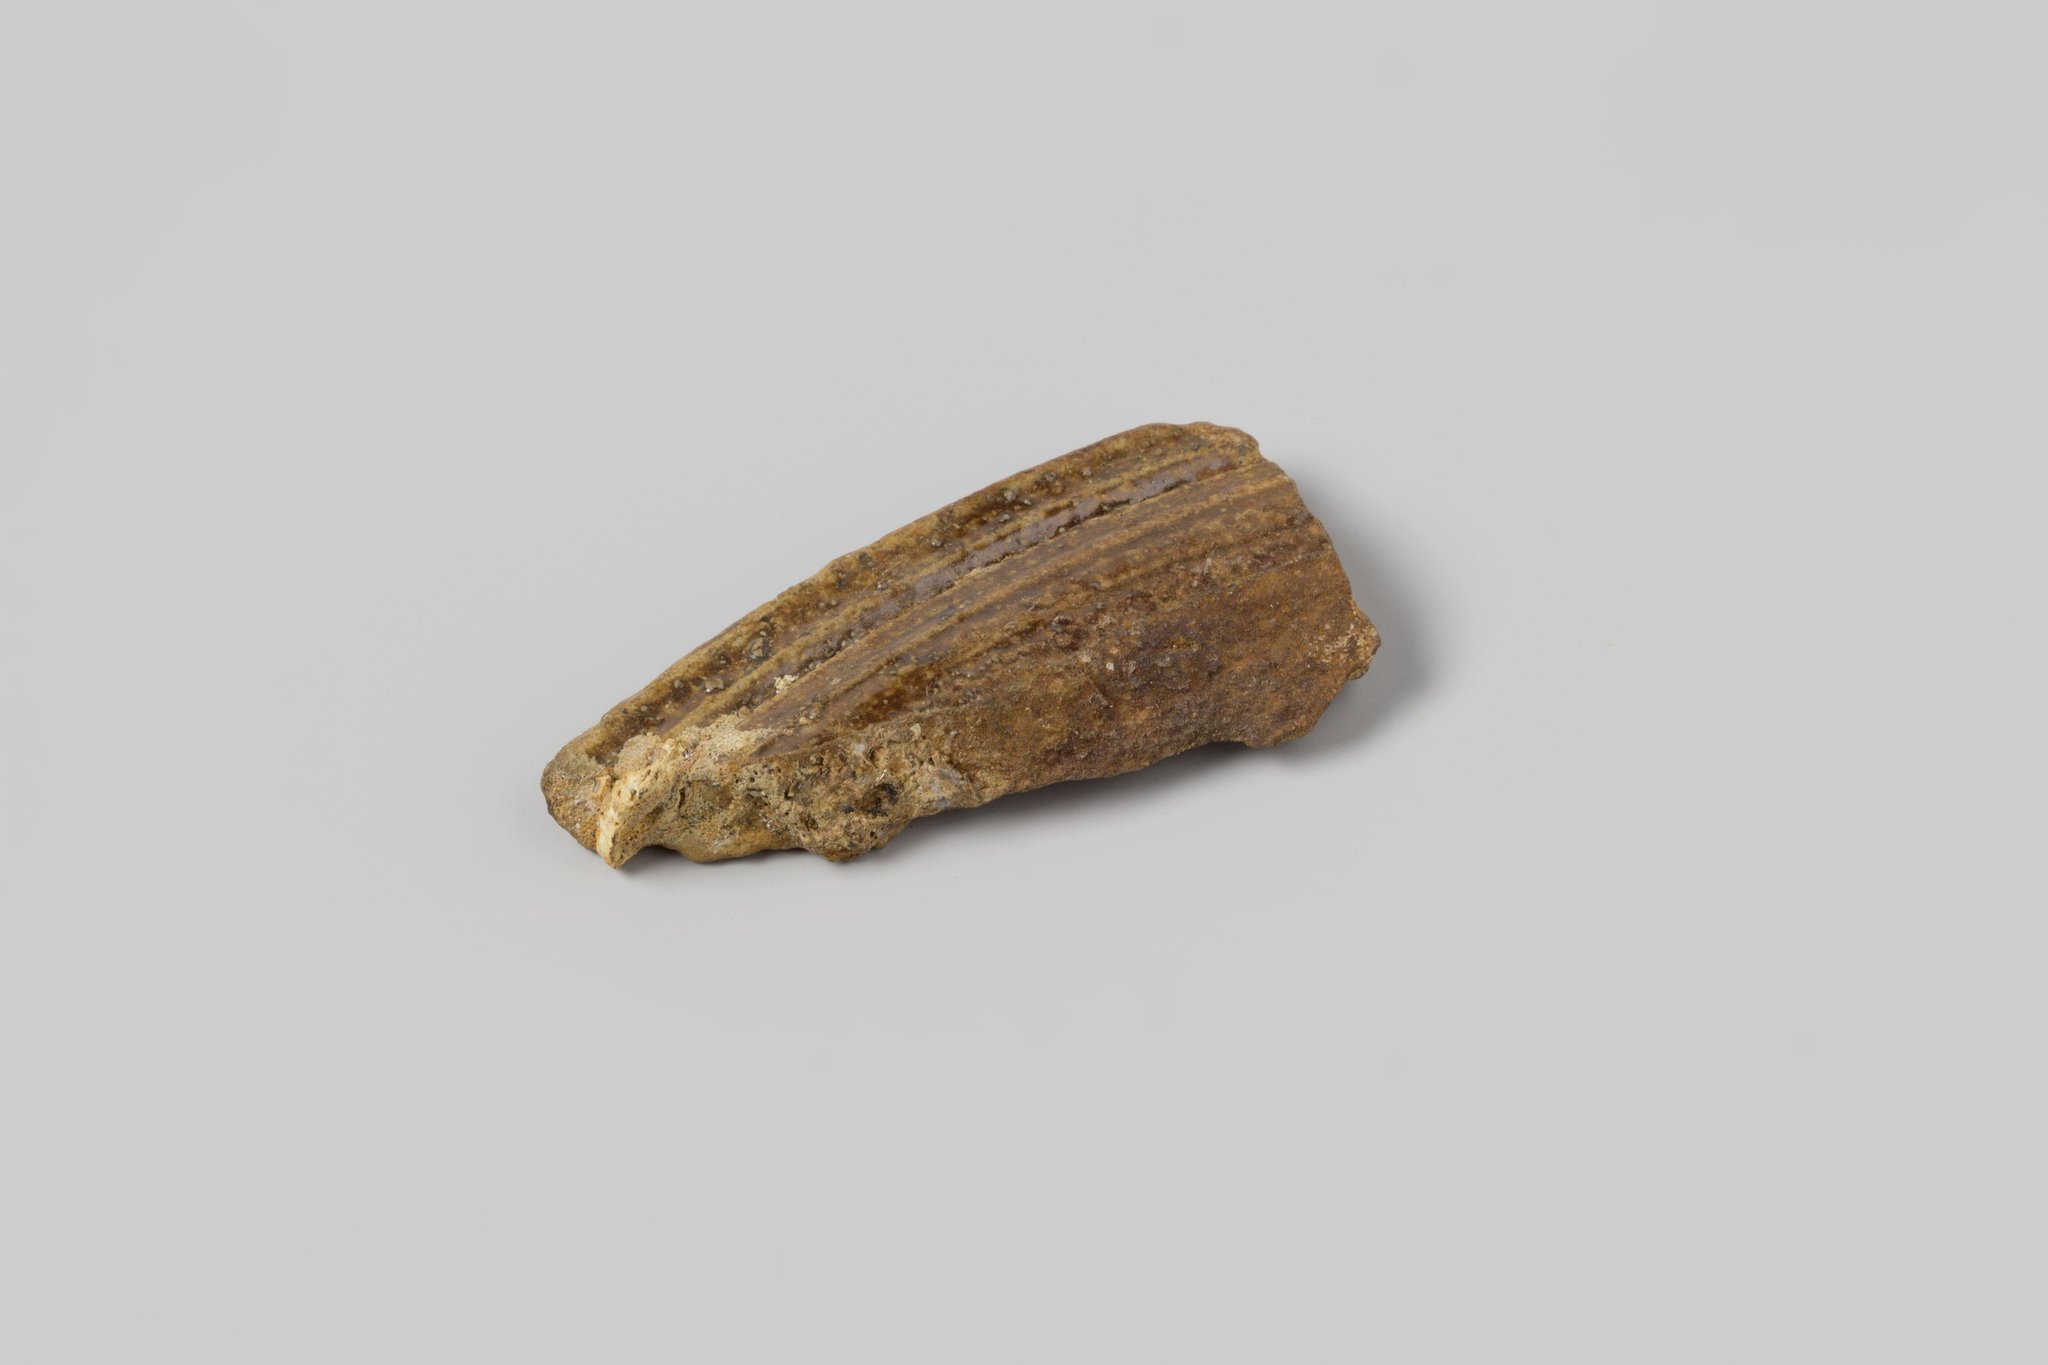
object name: storage jar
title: Scherf van een voorraadpot uit het wrak van de Oost-Indiëvaarder Hollandia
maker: Anonymous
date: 1700-1743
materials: stoneware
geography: cologne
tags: verenigde oostindische compagnie, hollandia (schip), annet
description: Stoneware, Rhenish, Langerwehe-ware, storage-jar; fragm of rim, sim. NG 1980-27H909: flat outer edge with engraved bands along.